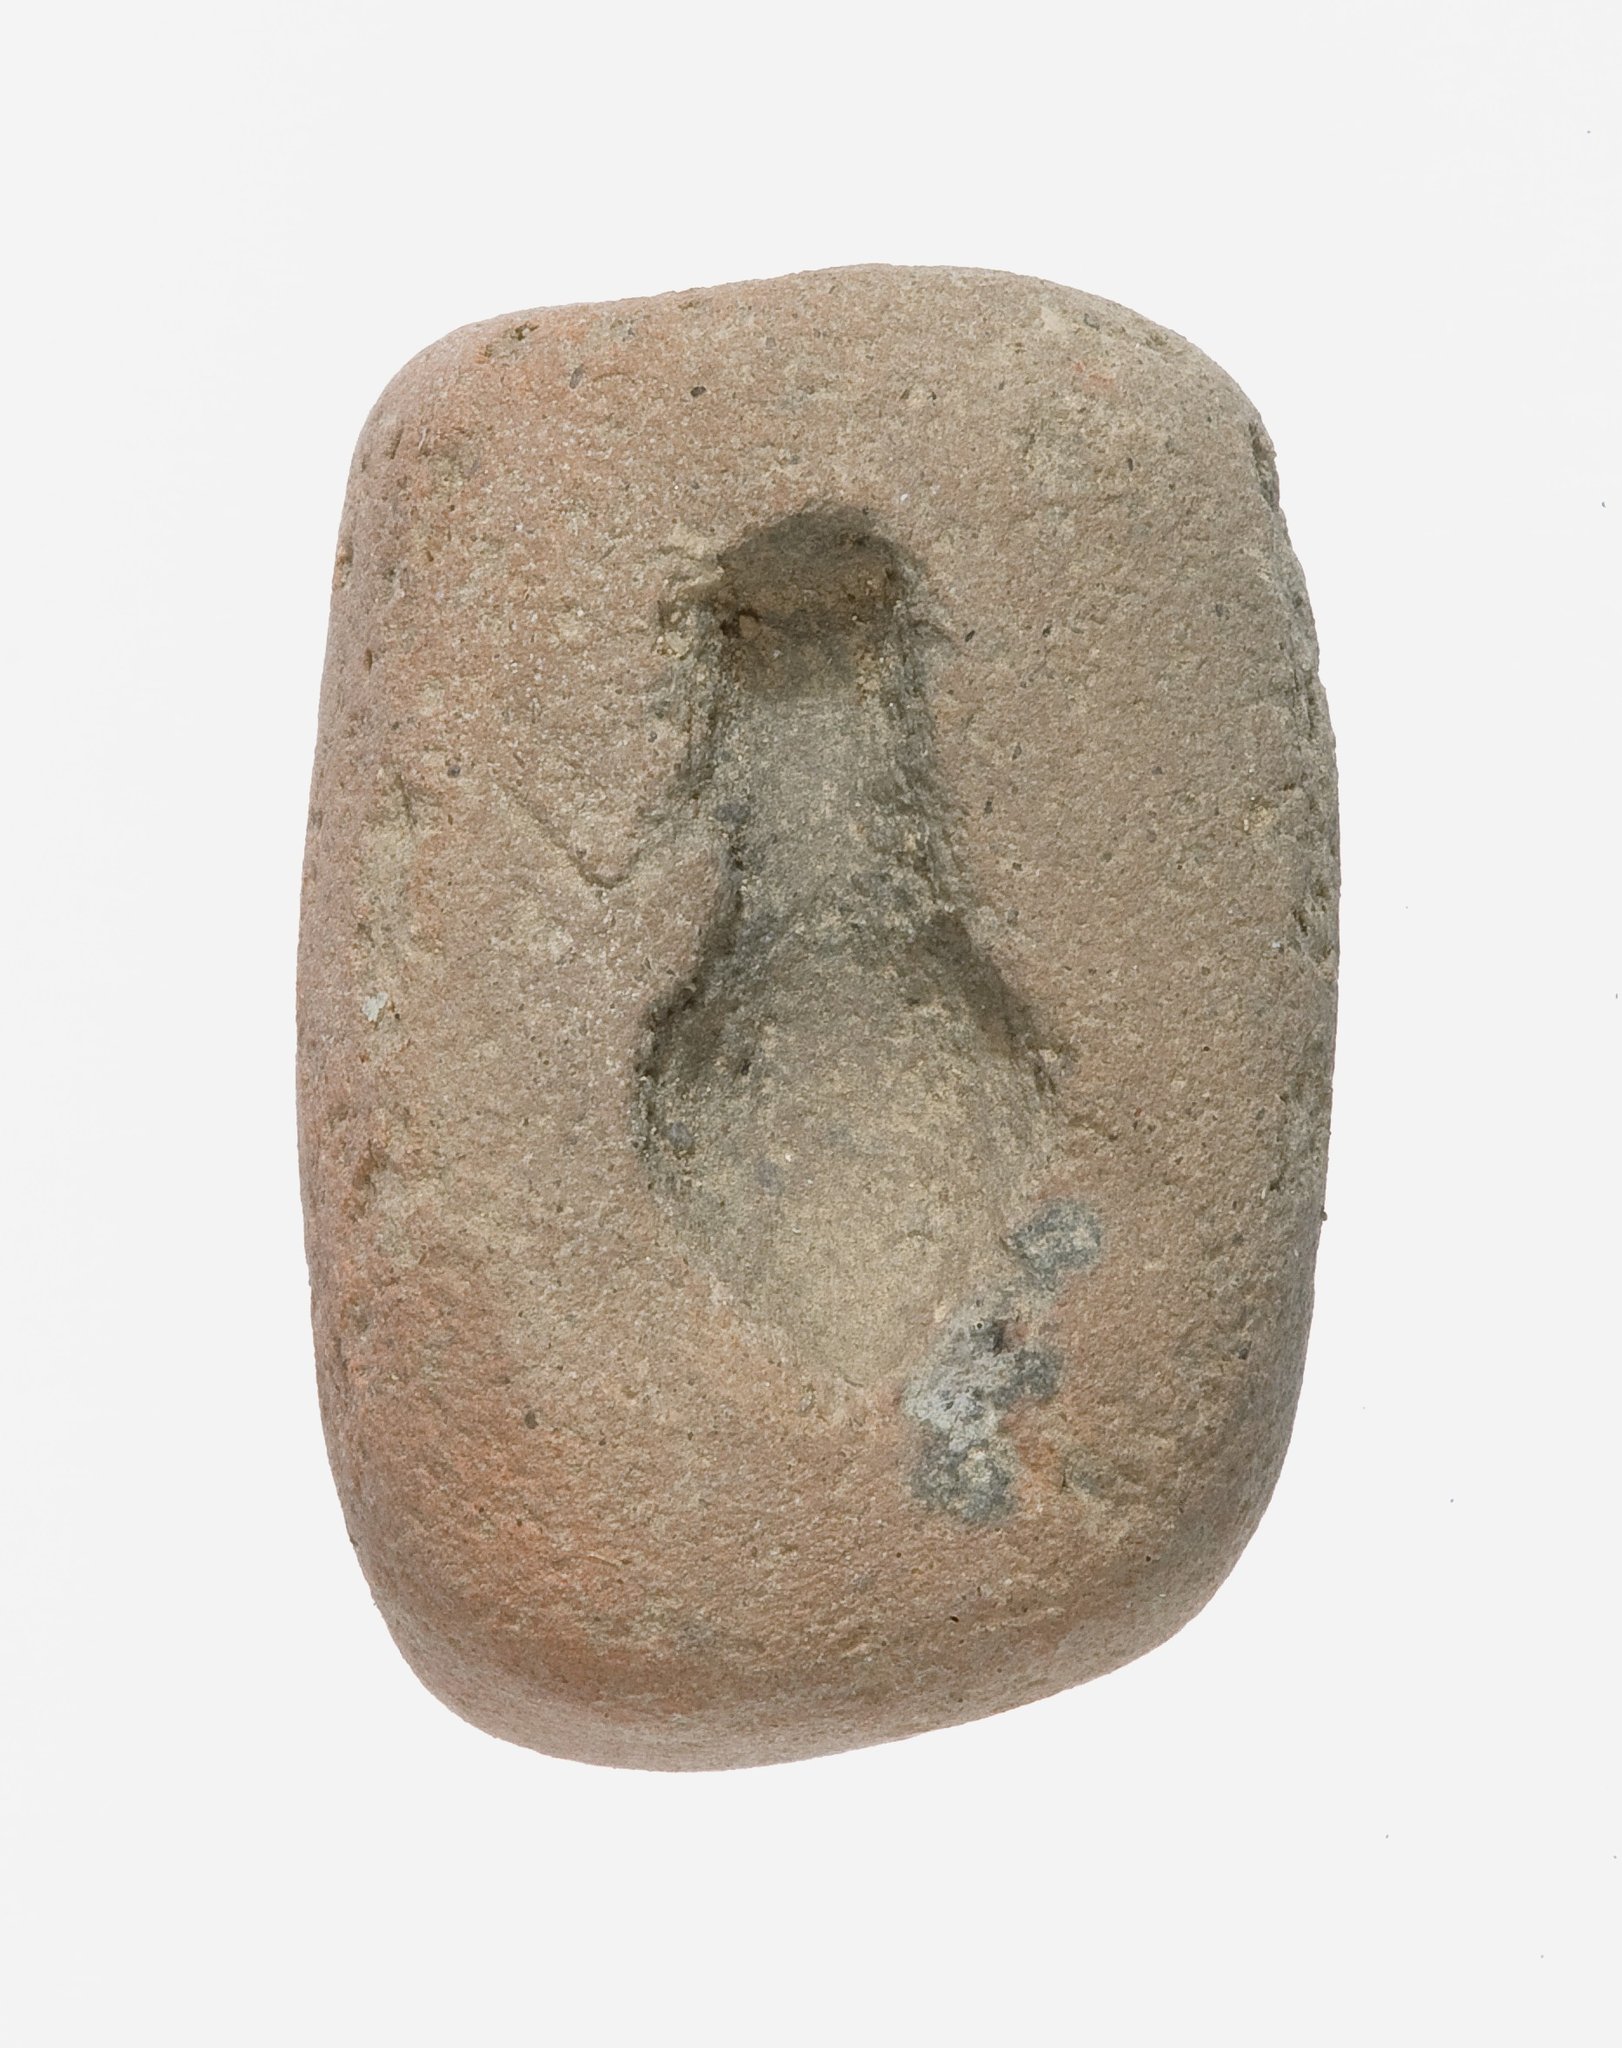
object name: mold, bead, nefer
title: Mold for a Nefer Bead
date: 1390-1352 BCE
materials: pottery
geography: egypt